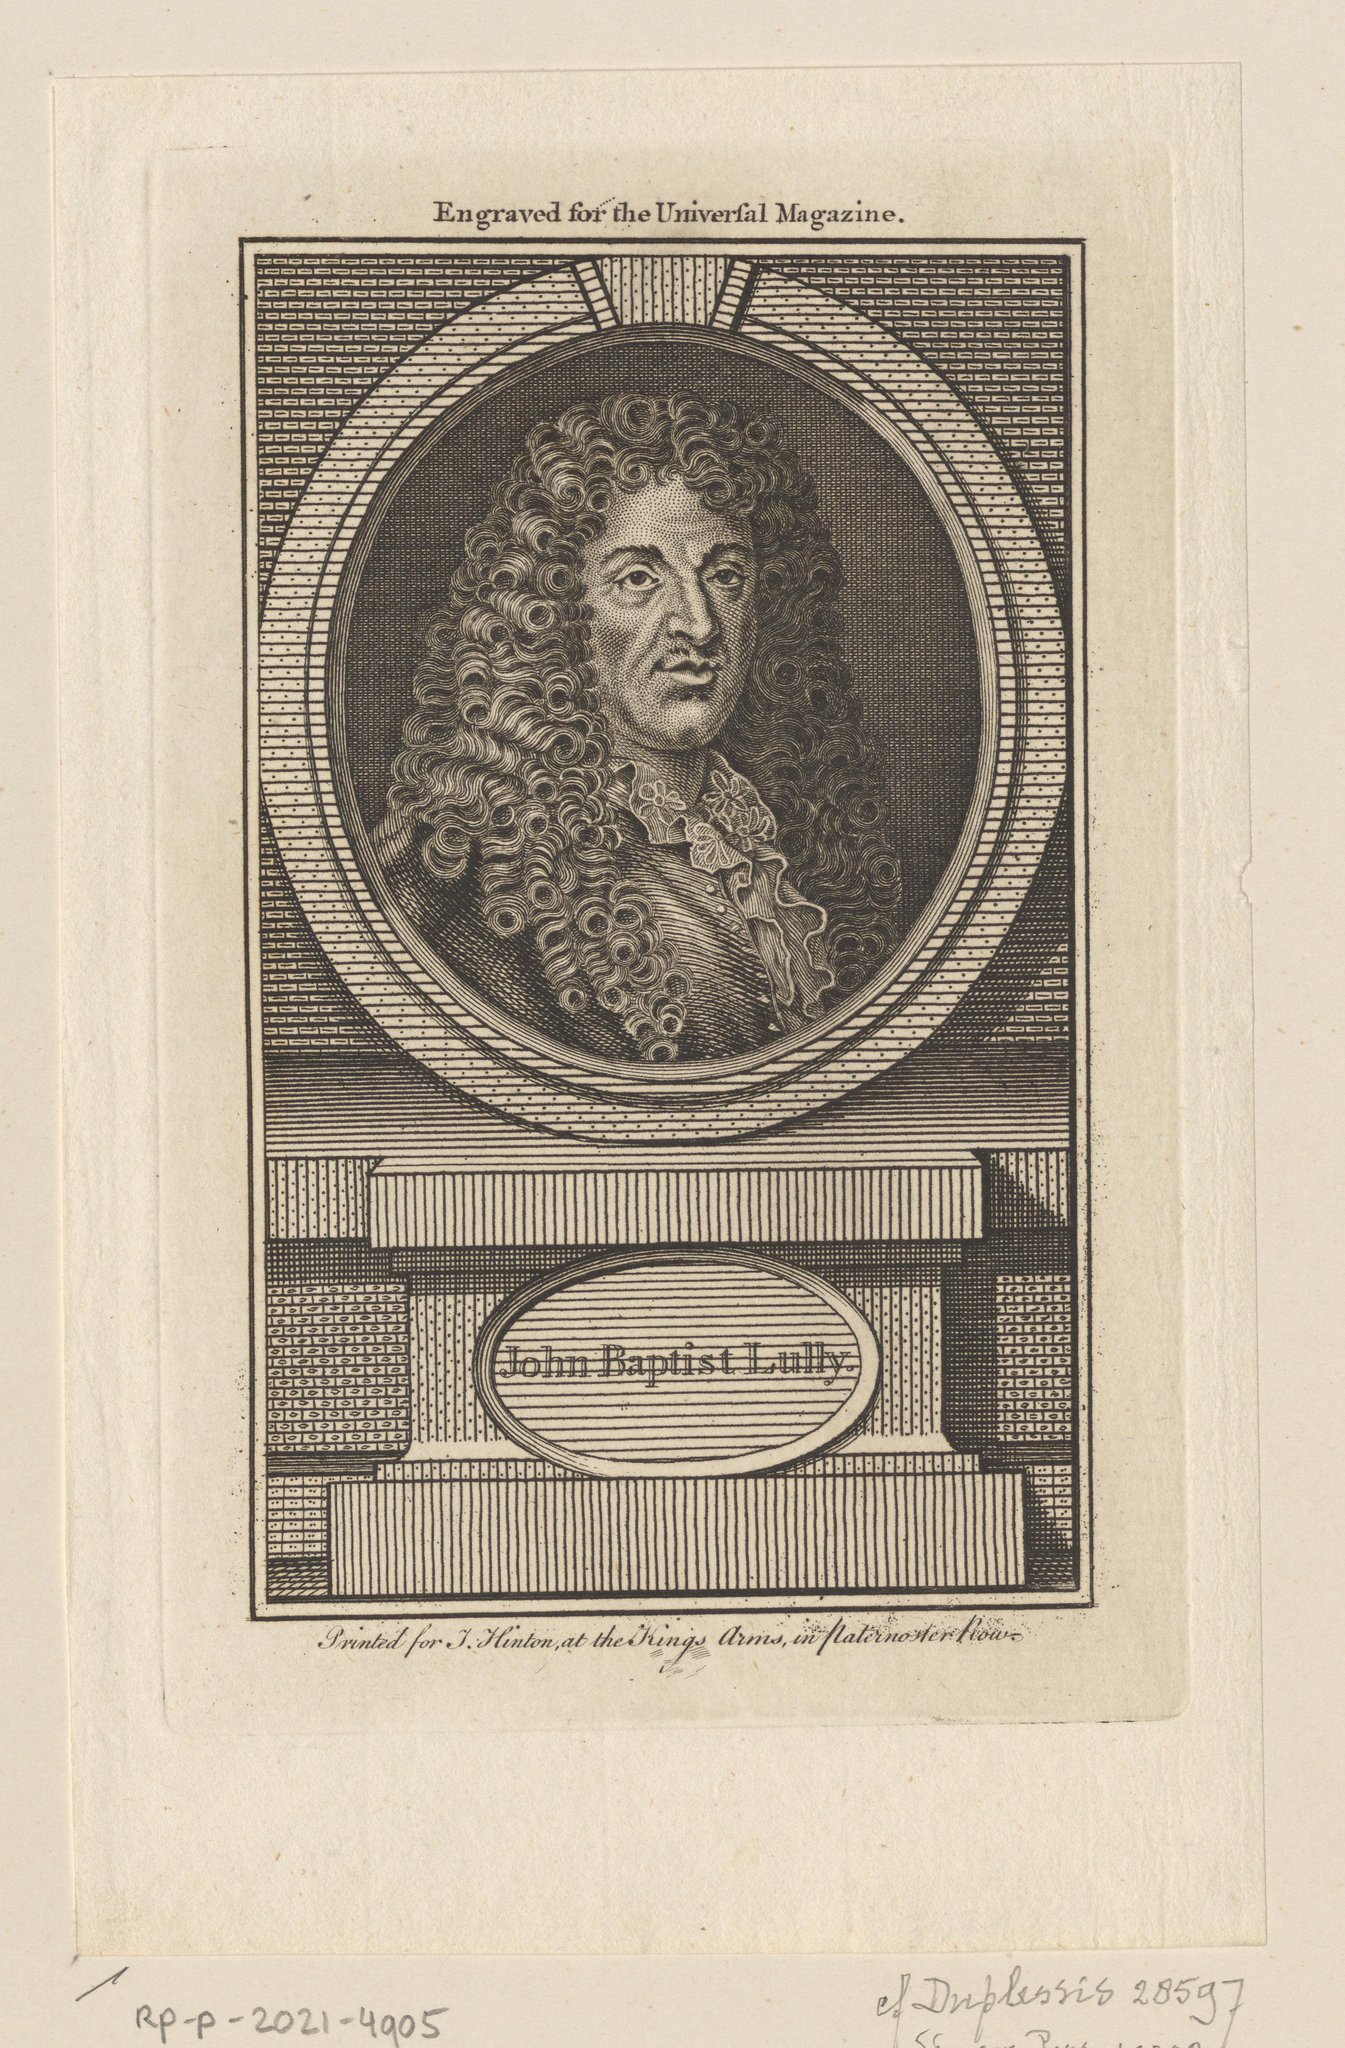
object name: print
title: Portret van Jean-Baptiste Lully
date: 1712-1779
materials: paper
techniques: etching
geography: england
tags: paris, jean-baptiste lully, ornament ~ medallion, historical persons, portrait of composer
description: Prent waarschijnlijk uit: The Universal Magazine of Knowledge and Pleasure (1779), vol. 65, nr. 455, december 1779.